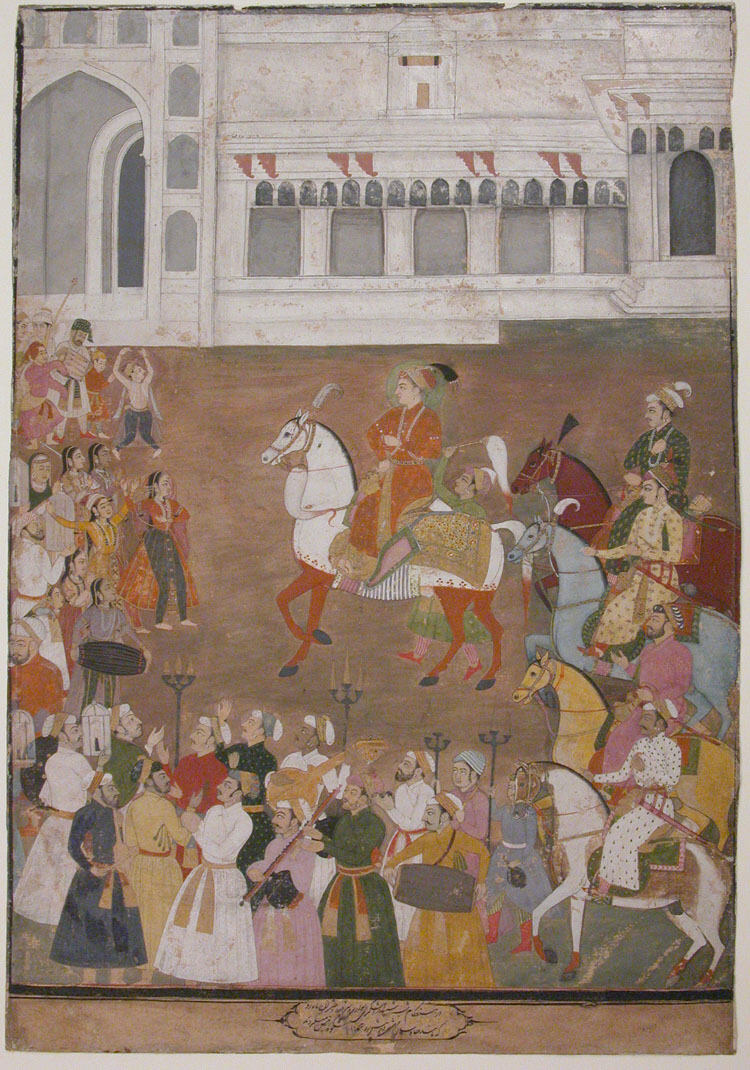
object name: illustrated album leaf or single work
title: State Entry of Dara Shiku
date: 1601-1700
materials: paper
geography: india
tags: men,women,horses